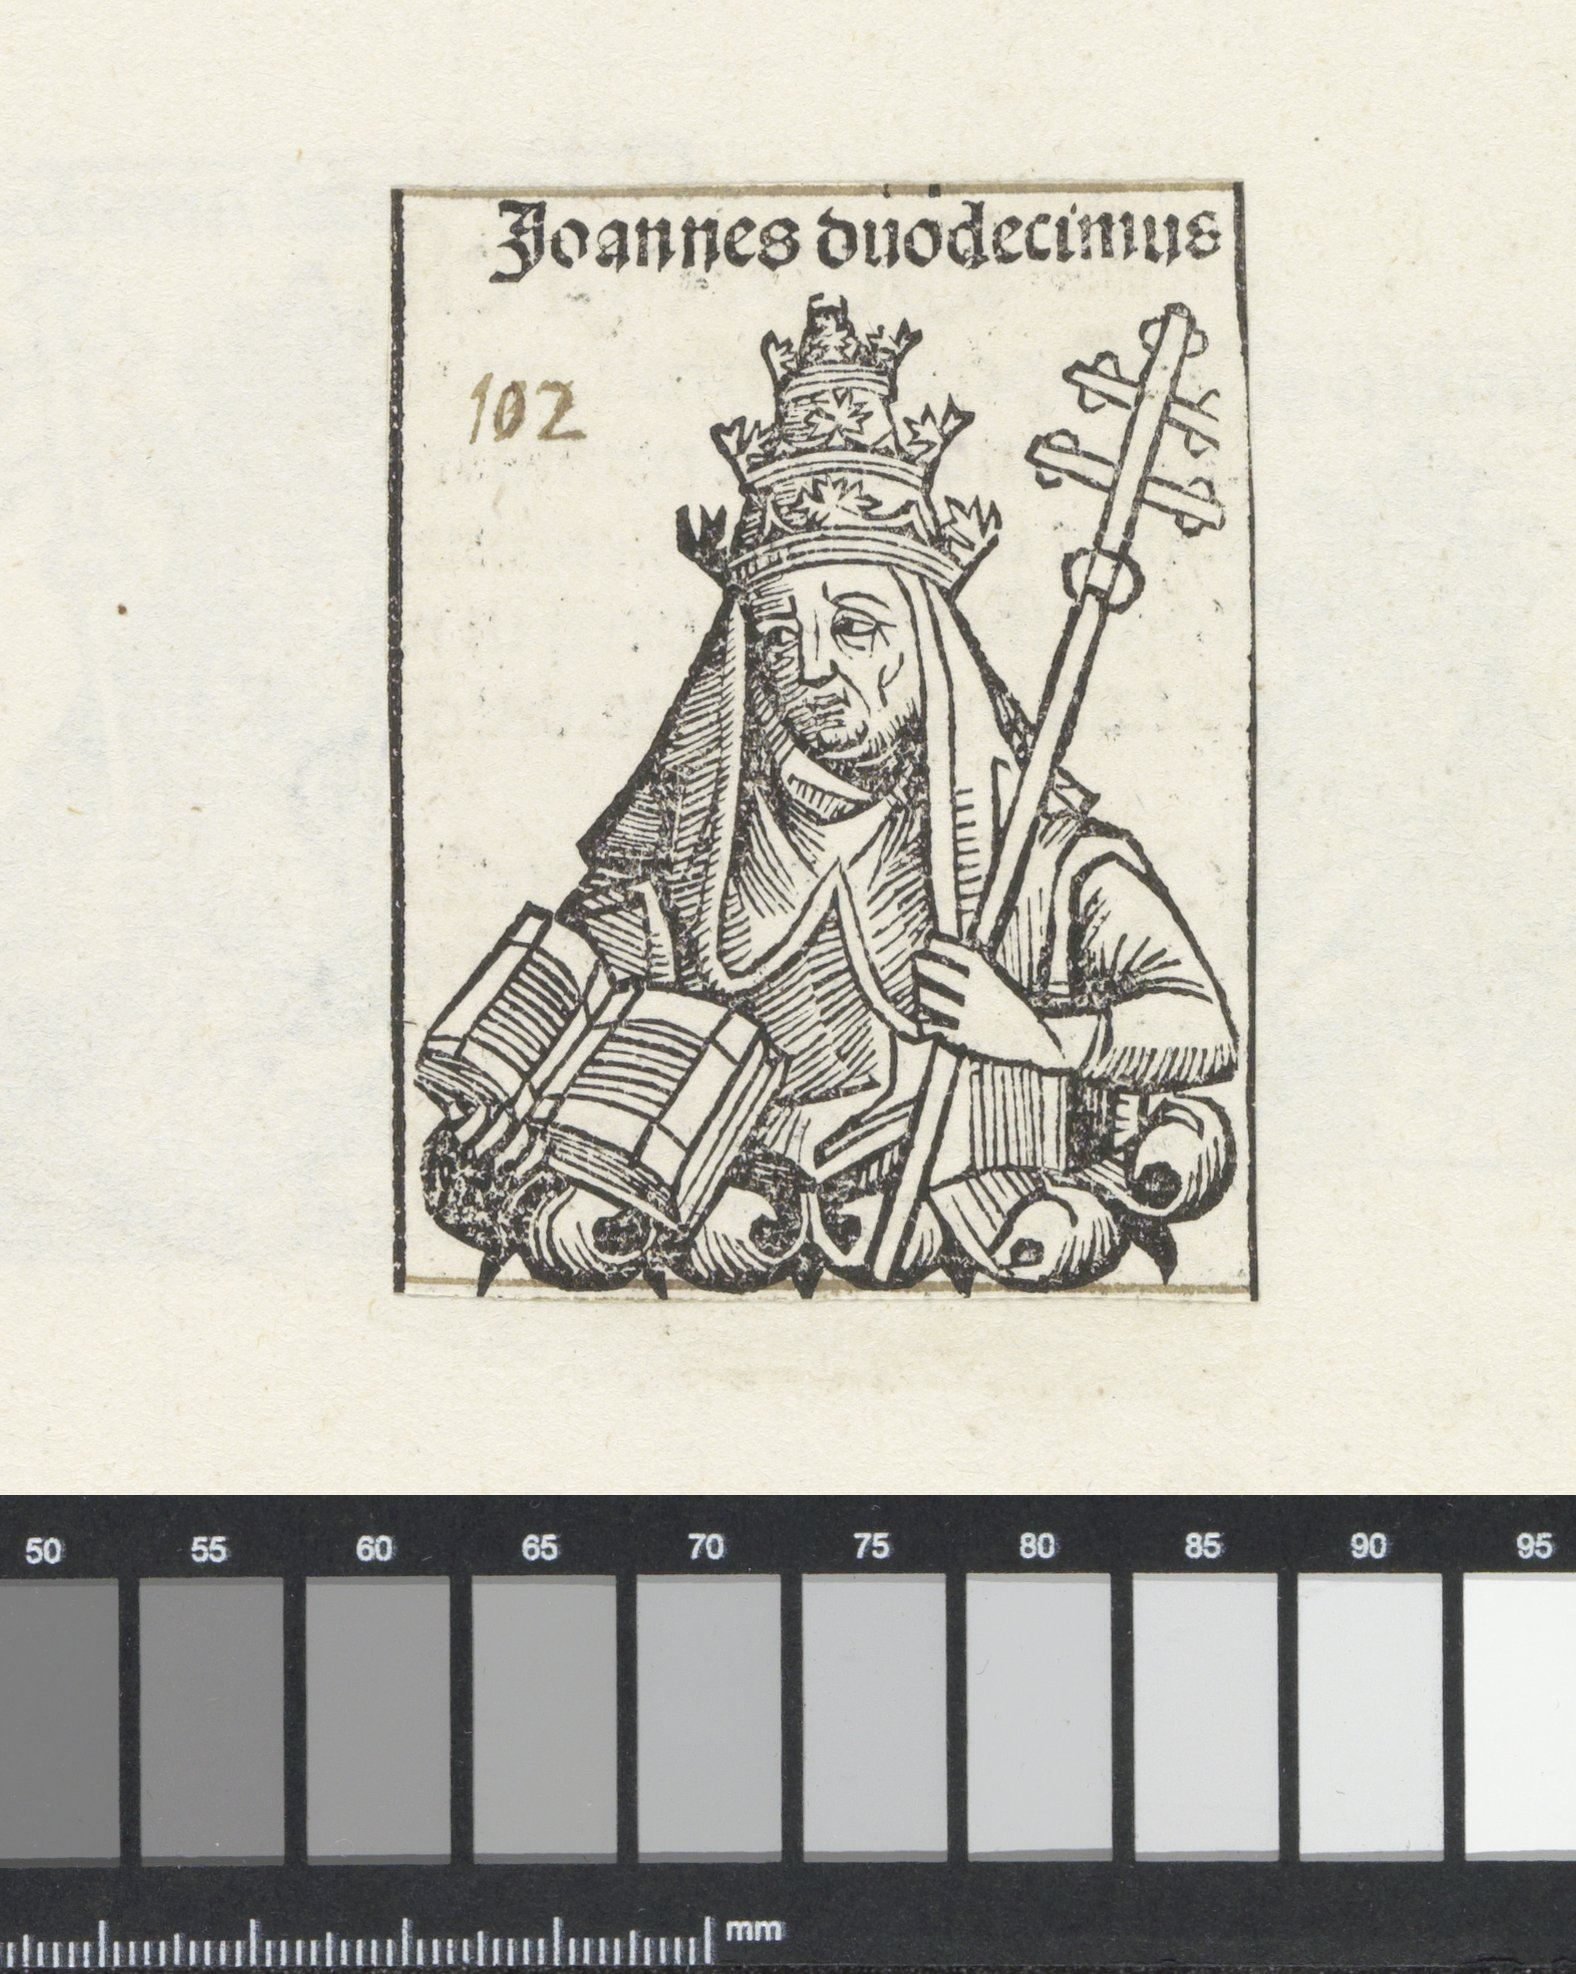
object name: book illustration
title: Liber Chronicarum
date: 1493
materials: paper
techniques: letterpress printing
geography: nuremberg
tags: rome, pope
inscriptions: inscription: ‘102’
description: Een bloemkelk met een paus. Hij draagt een tiara en heeft een opengeslagen boek en een staf met een dubbel kruis in zijn handen. De voorstelling is onderdeel van de opeenvolging pausen in de Liber Chronicarum. De tekst identificeert de man als Johannes XII. De prent maakt deel uit van een album.